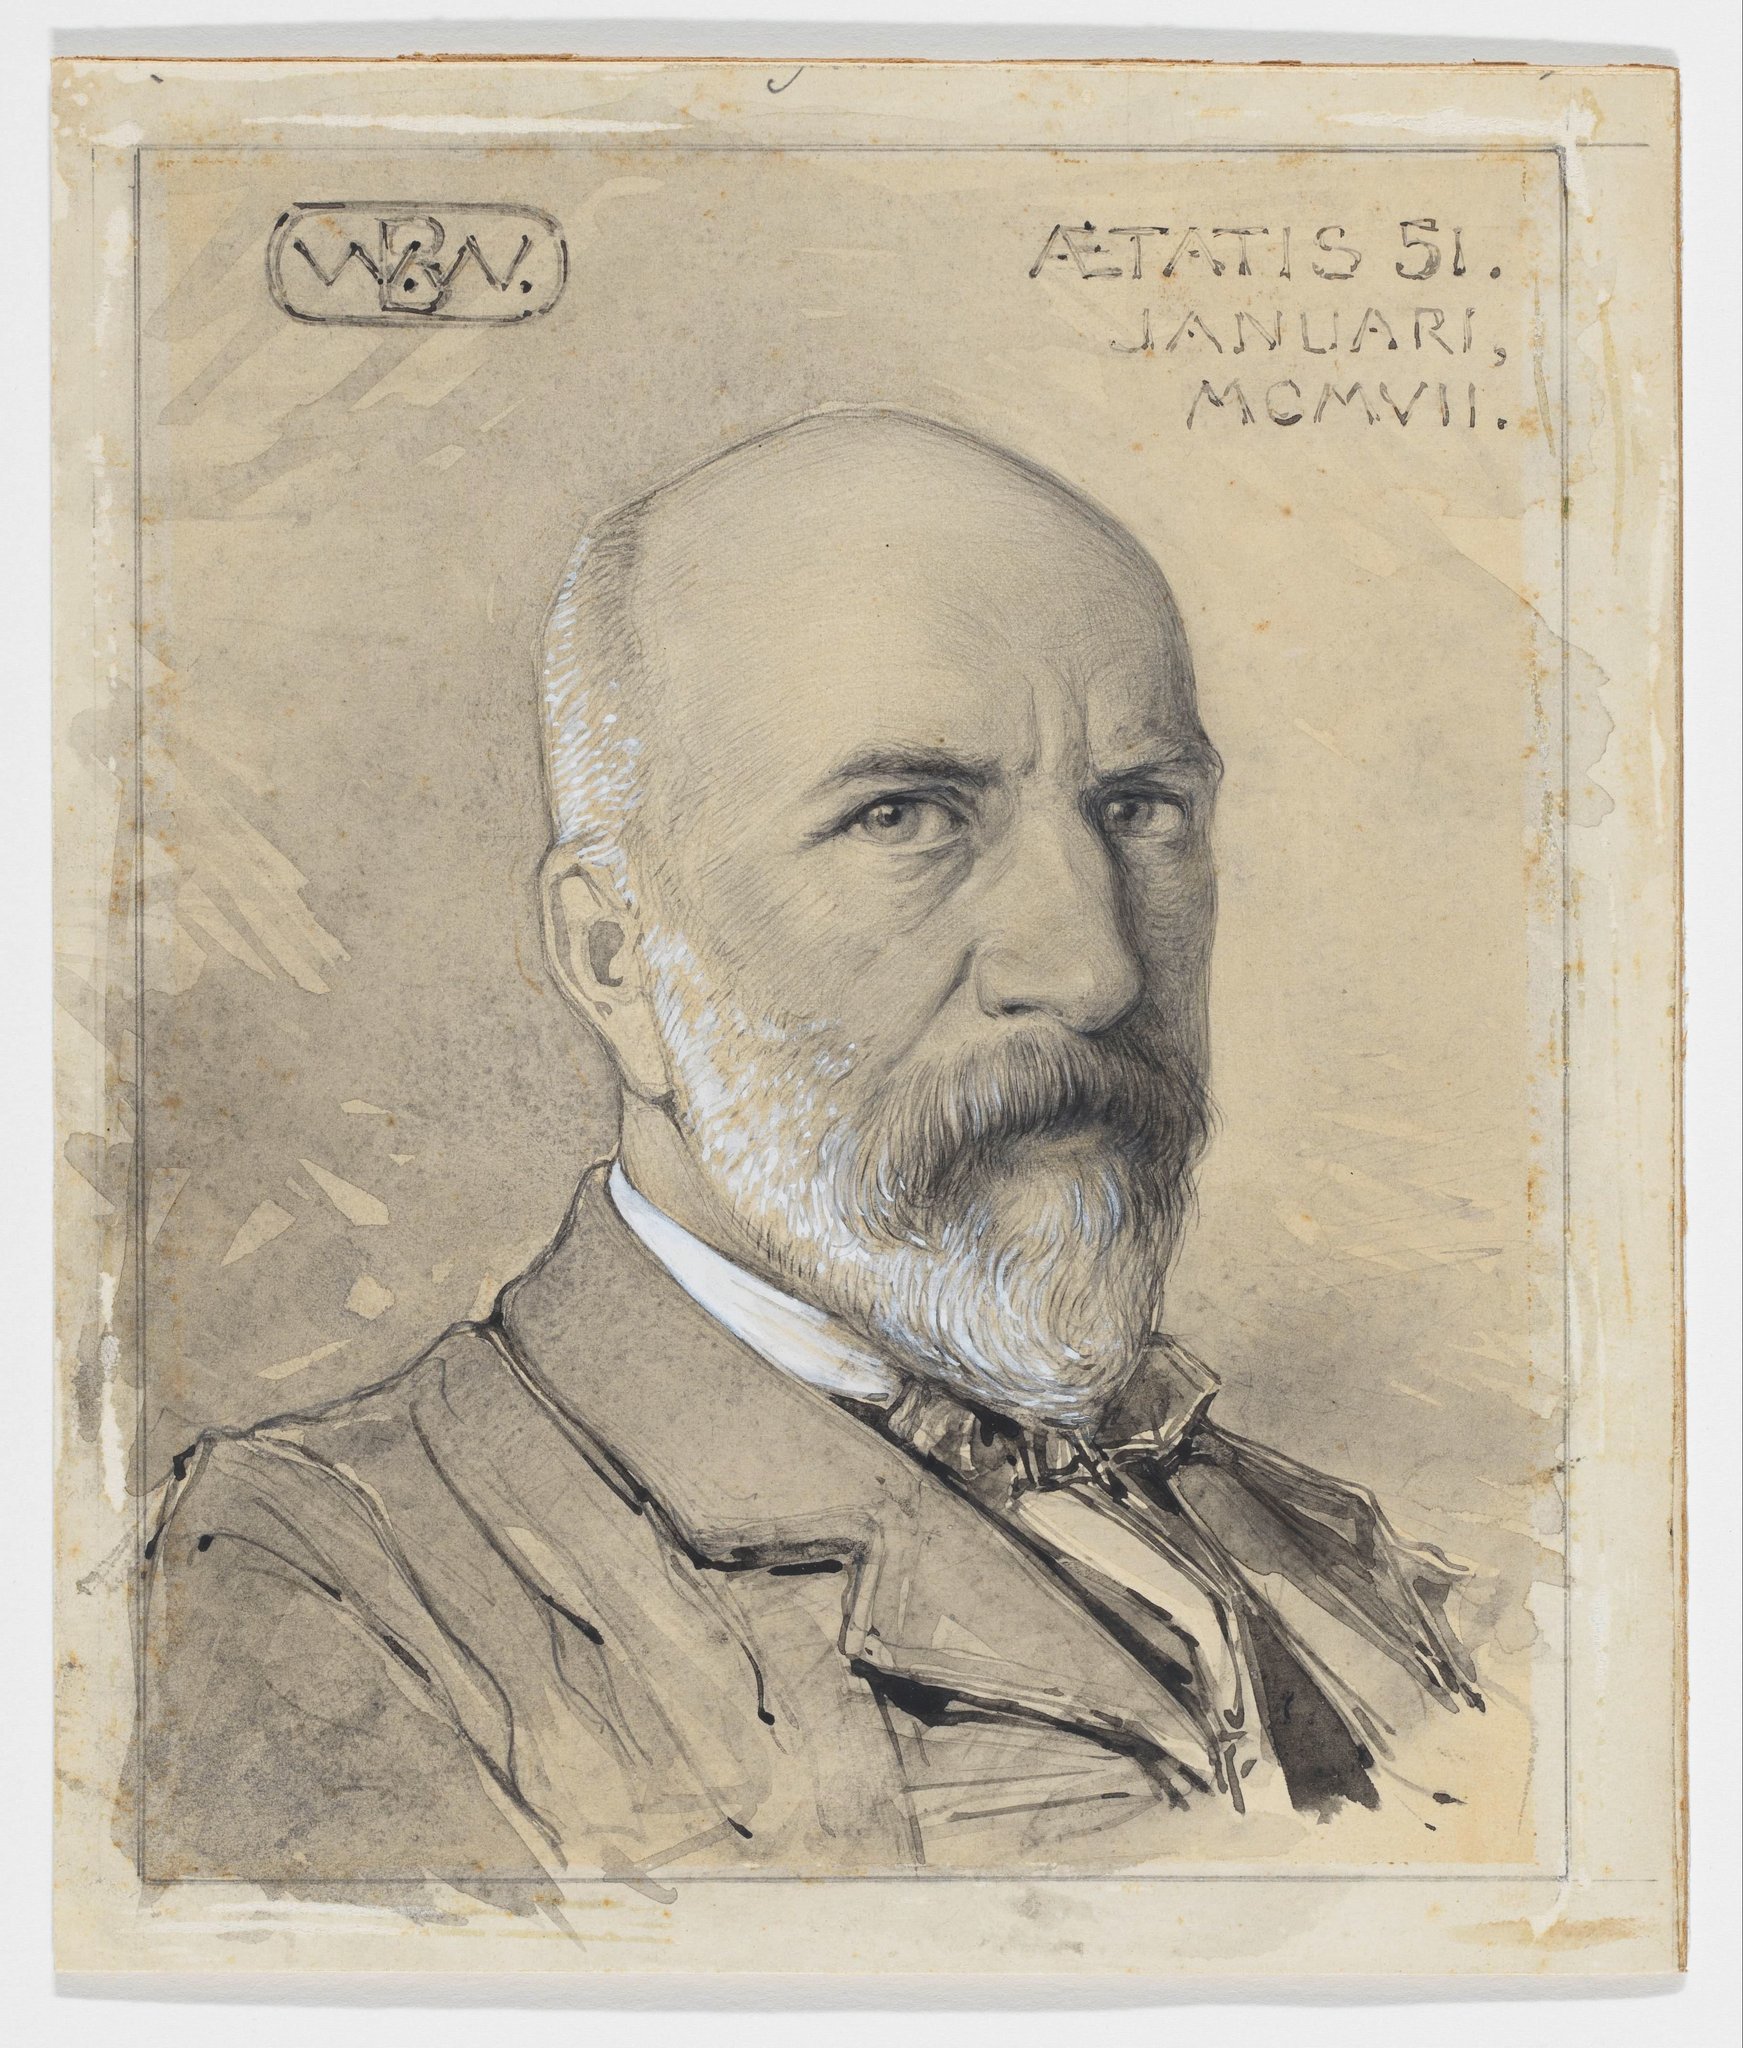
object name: drawing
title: Zelfportret op 51-jarige leeftijd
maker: bernard willem wierink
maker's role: draughtsman, print maker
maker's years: 1856-1939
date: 1901-1907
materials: cardboard, pencil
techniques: brush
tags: amsterdam, print maker, draughtsman, bernard willem wierink, historical persons